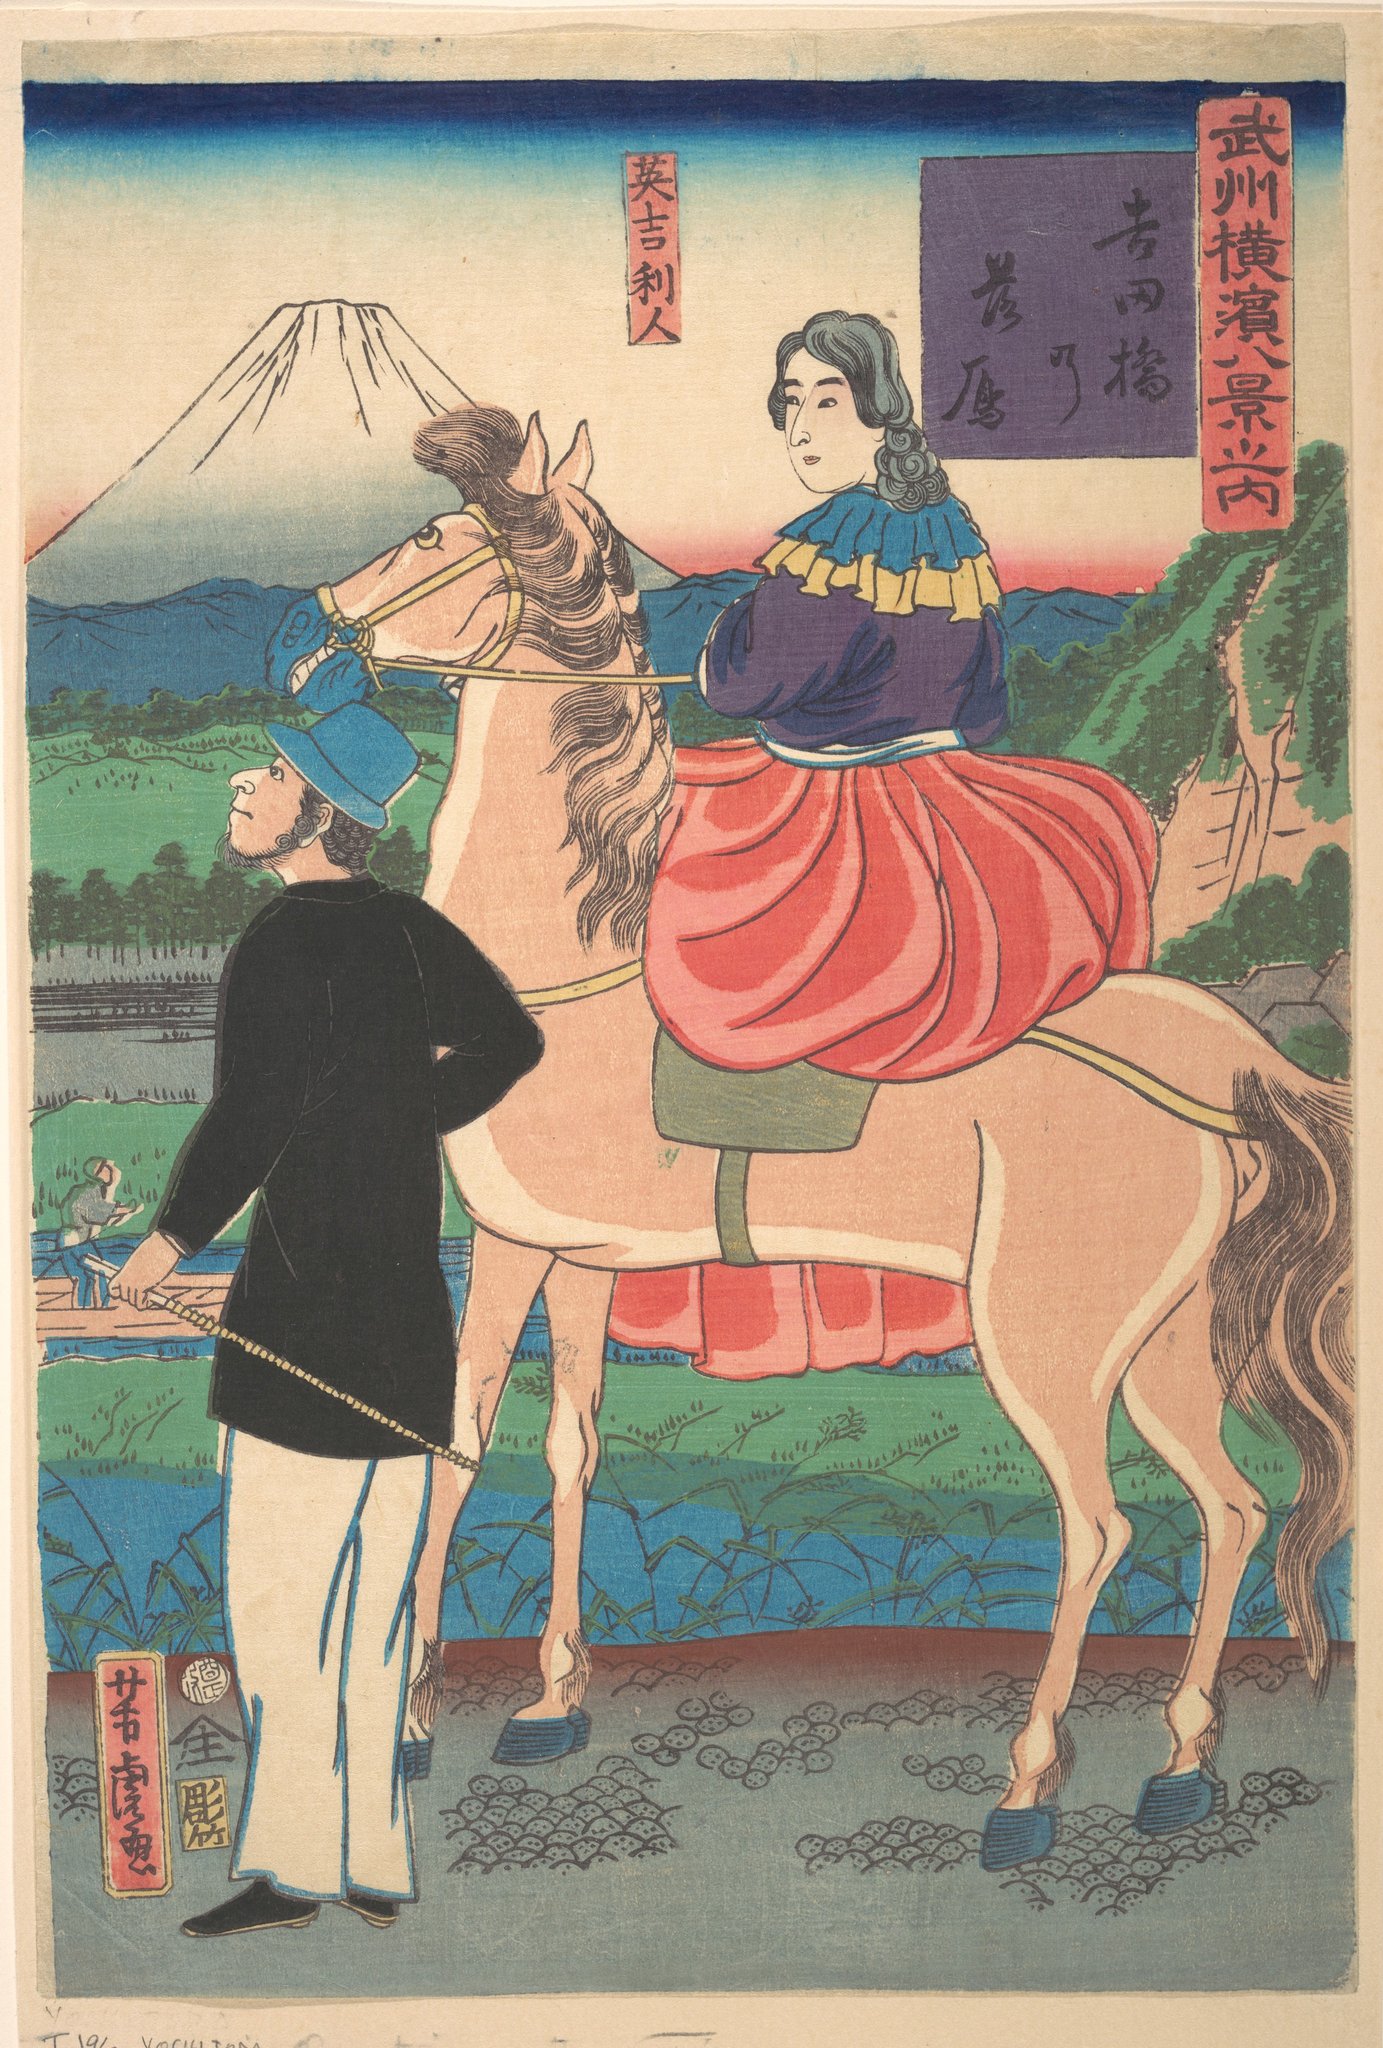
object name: print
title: Descending Geese at Yoshida Bridge [English Couple] (Yoshidabashi no rakugan [Igirisujin])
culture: japanese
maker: utagawa yoshitora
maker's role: artist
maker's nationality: japanese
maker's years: 1845-1880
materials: ink, paper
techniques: woodblock print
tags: men,women,horses,mountains